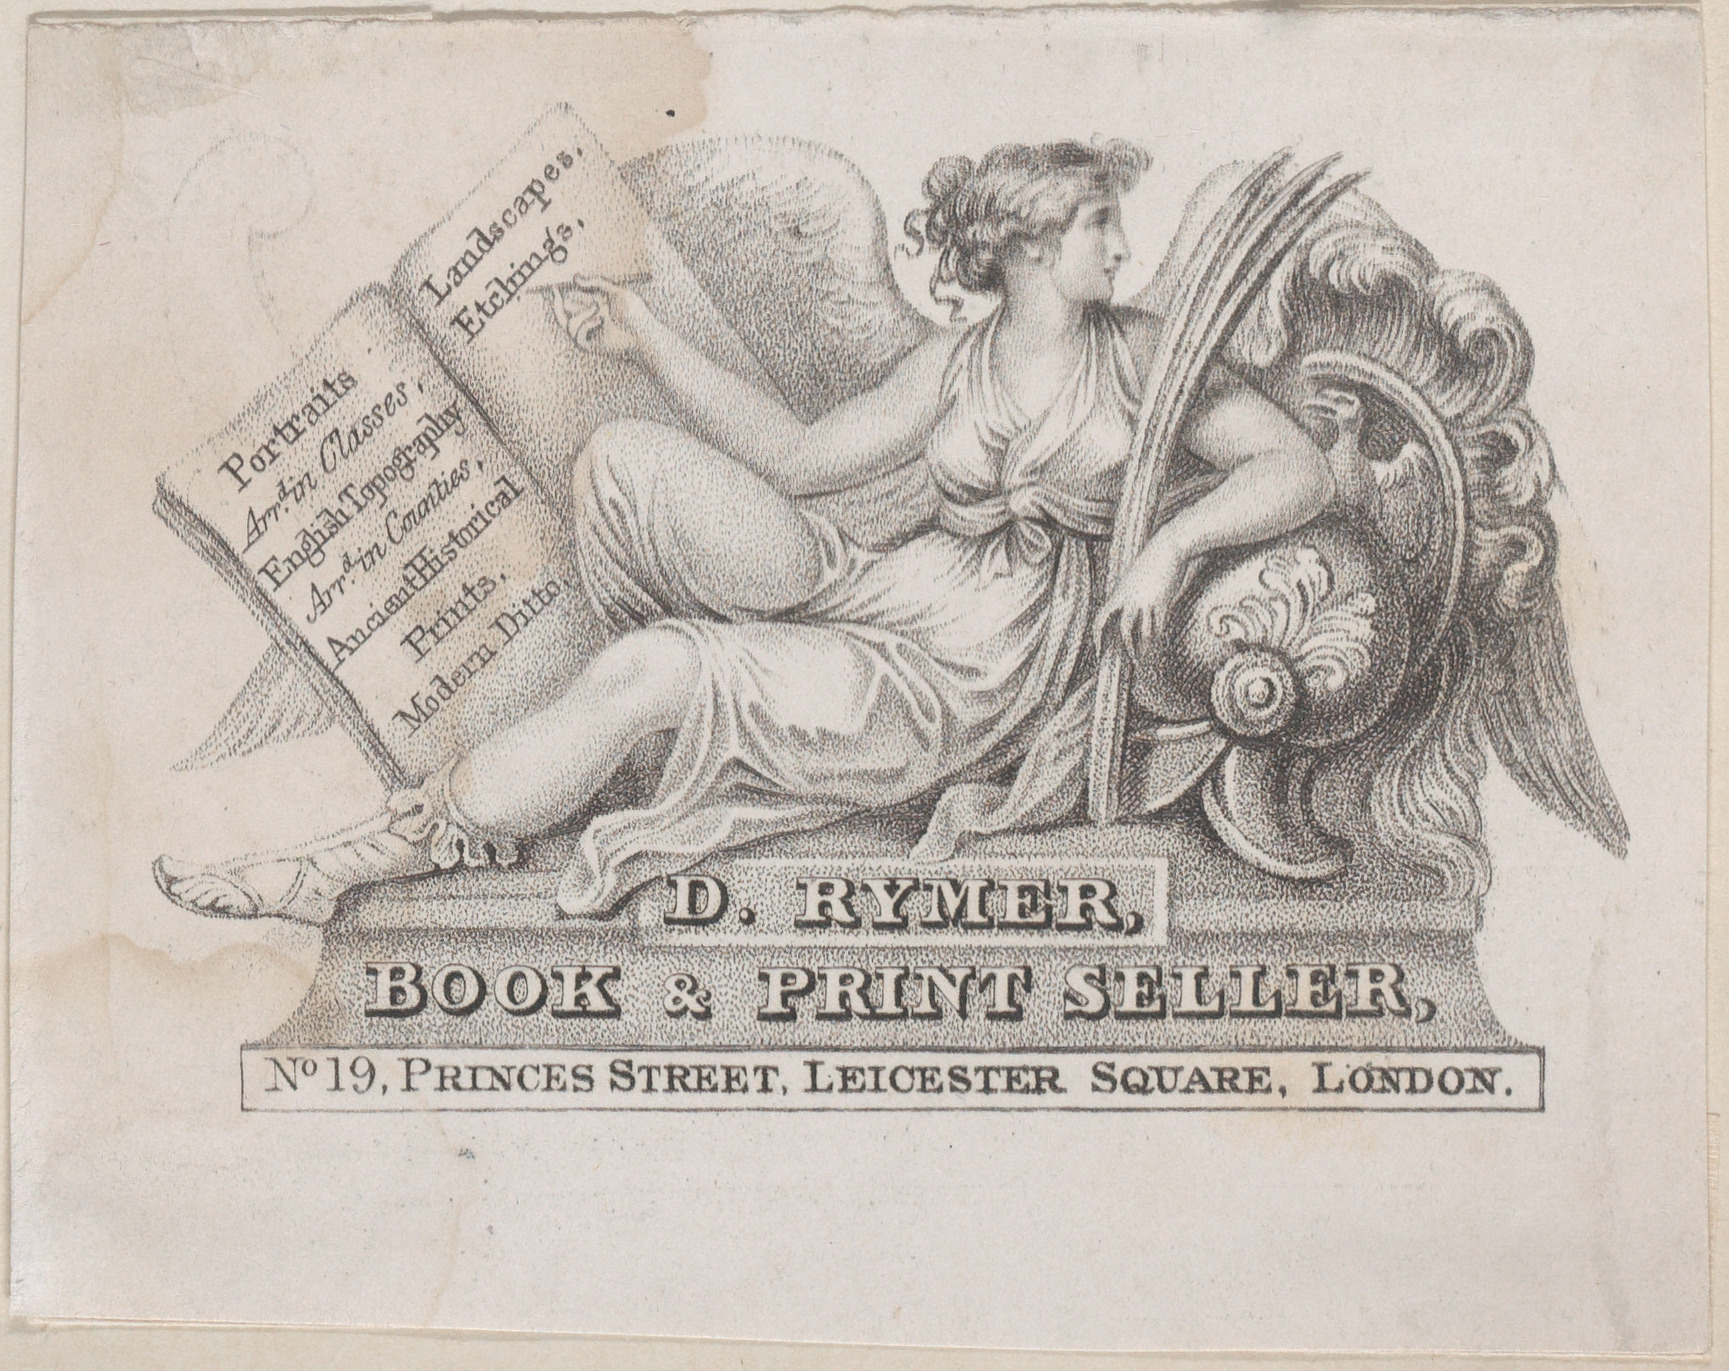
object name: print, trade card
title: Trade Card for D. Rymer, Book & Print Seller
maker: anonymous, british, 18th century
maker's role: artist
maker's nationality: british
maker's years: 1700-1800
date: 1701-1800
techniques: engraving